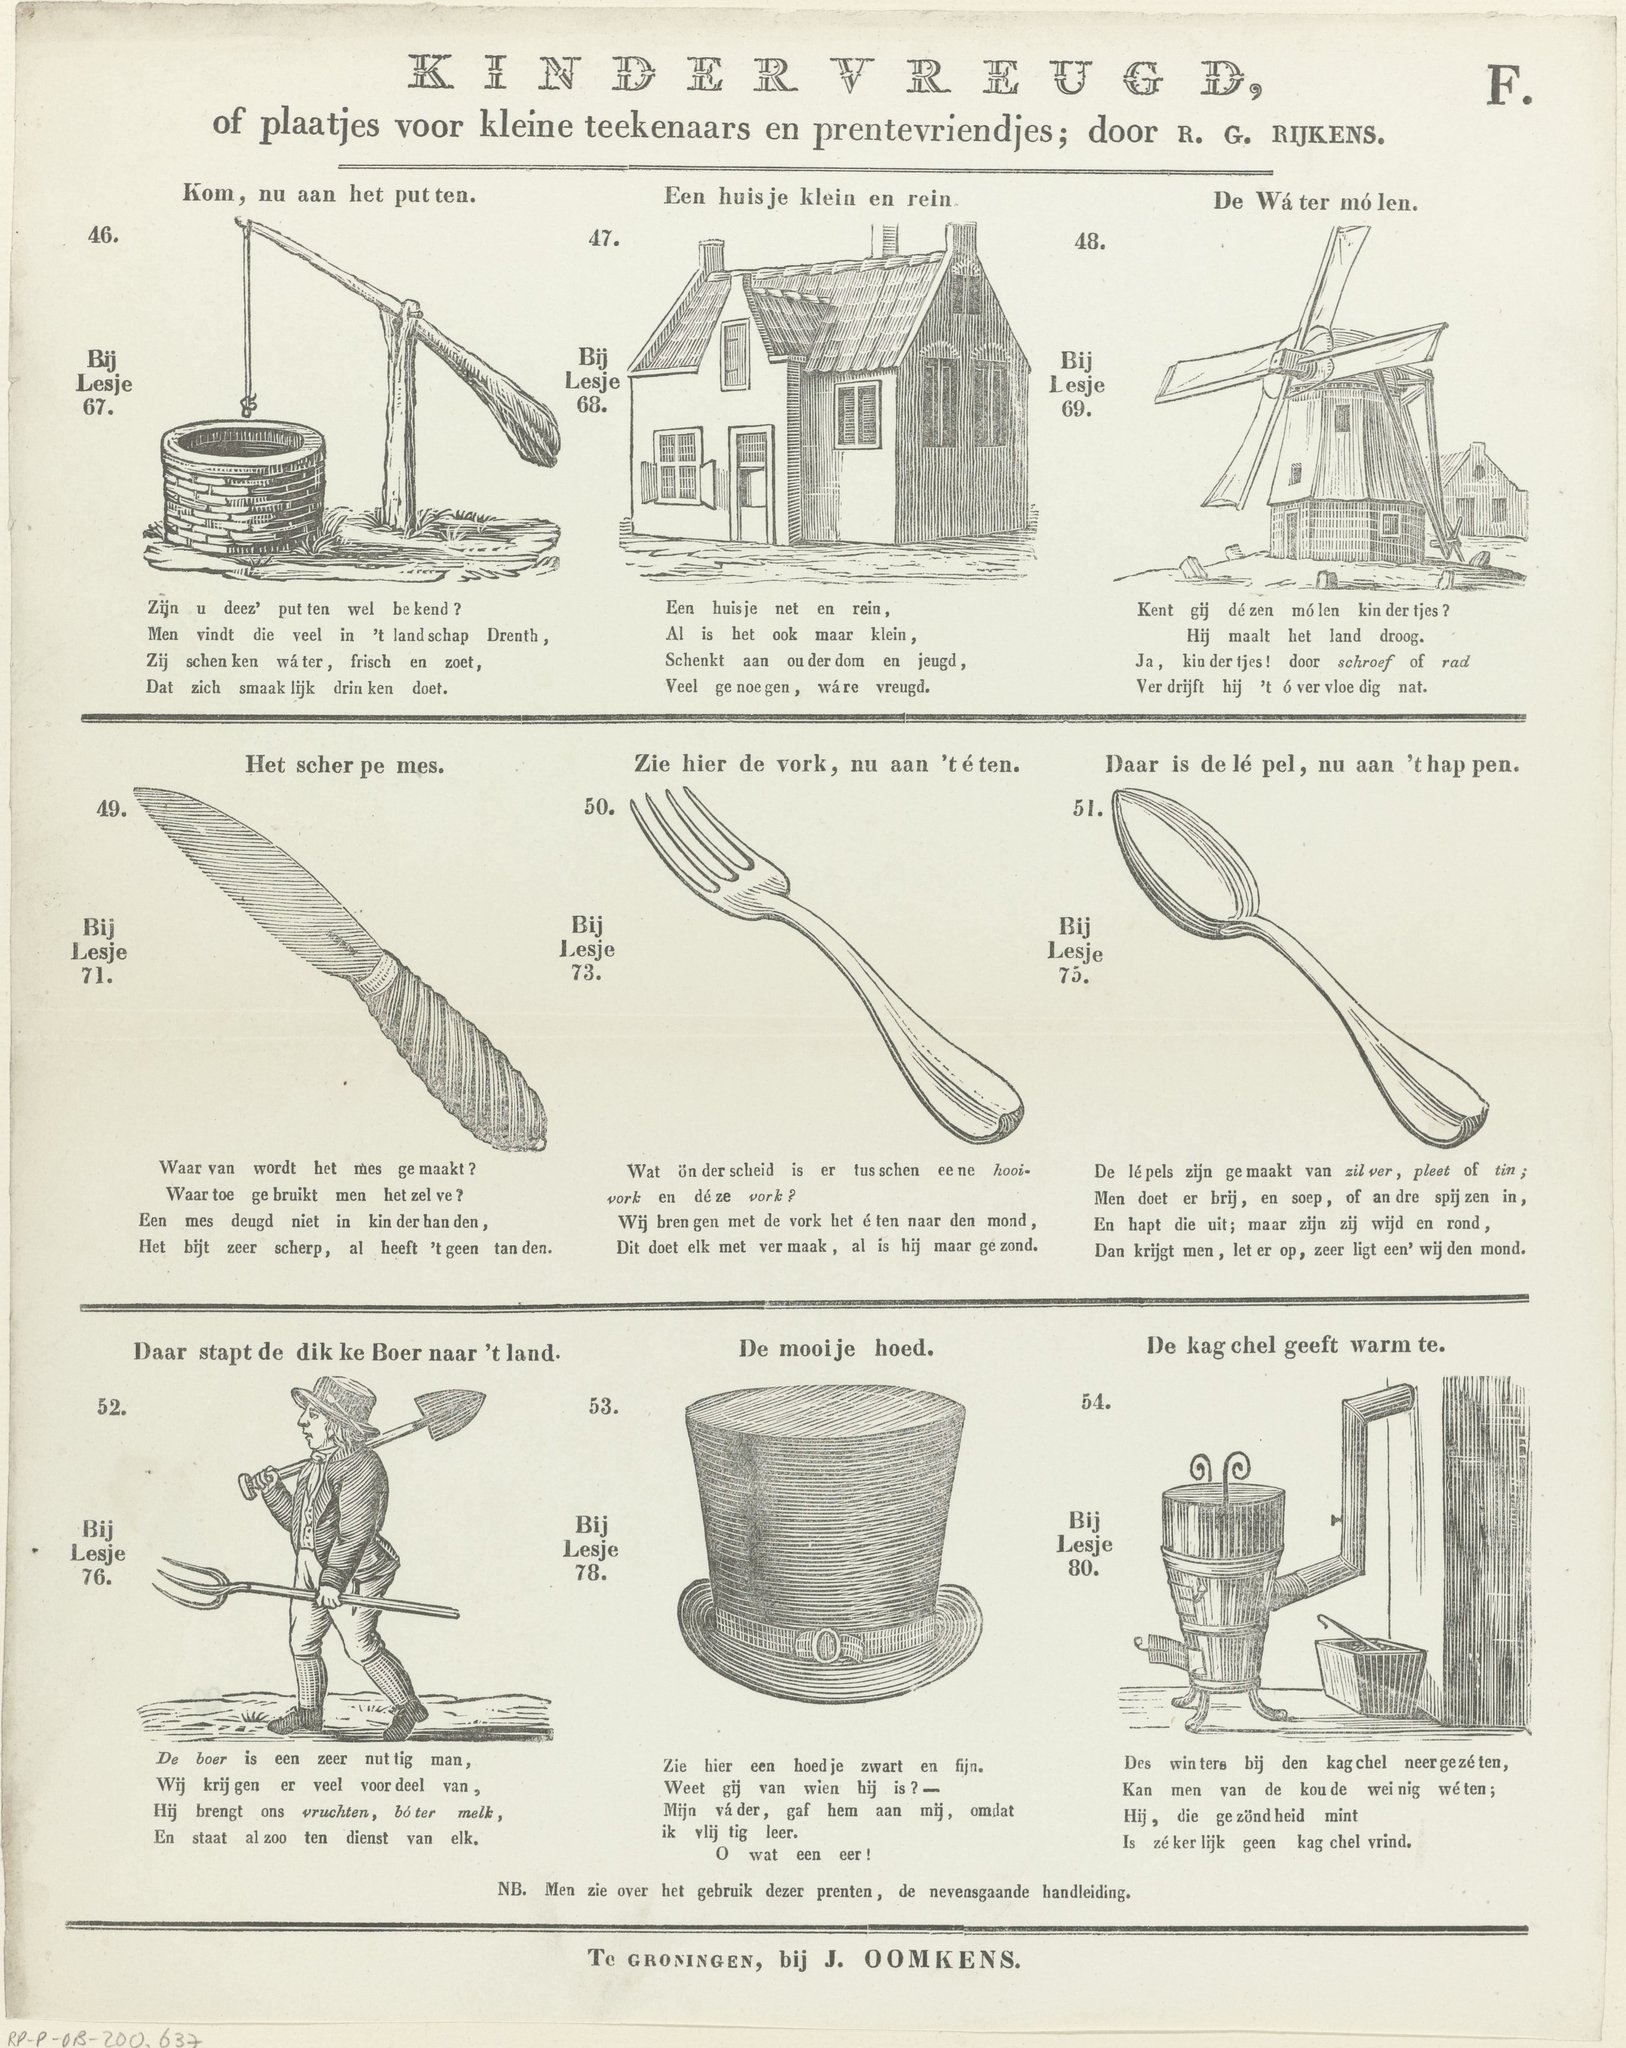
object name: print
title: Kindervreugd / of plaatjes voor kleine teekenaars en prentevriendjes; door R. G. Rijkens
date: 1808-1844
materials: paper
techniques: letterpress printing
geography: groningen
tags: well, fork, table-knife, housing, head-gear: hat, spoon, education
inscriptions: collector's mark: Lugt 2760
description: Blad met 9 illustraties (genummerd 46-54) bij leesboekjes van R.G. Rijkens. Elk plaatje hoort bij een lesje uit de boekjes "Natuurlijke Lees-Leerwijze". Weergegeven zijn ondermeer een waterput, een huis, een molen, bestek en een hoed. Boven elke afbeelding een nummer en een titel en onder elke afbeelding een vierregelig vers. Links van elke afbeelding staat vermeld bij welke les het plaatje hoort. Gemerkt rechtsboven: F.